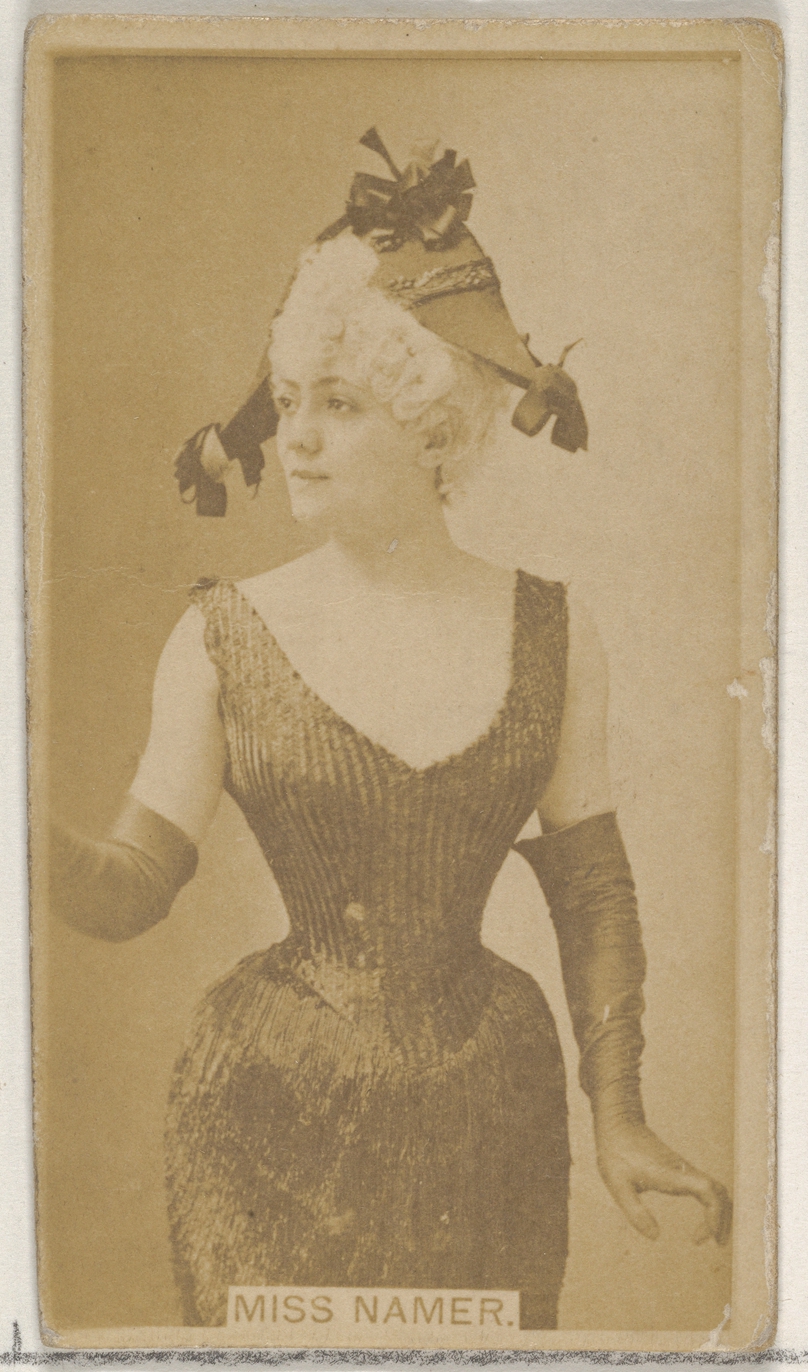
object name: photograph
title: Miss Namer, from the Actors and Actresses series (N45, Type 8) for Virginia Brights Cigarettes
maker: allen & ginter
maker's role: publisher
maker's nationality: american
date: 1888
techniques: albumen silver print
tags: portraits,women,actresses